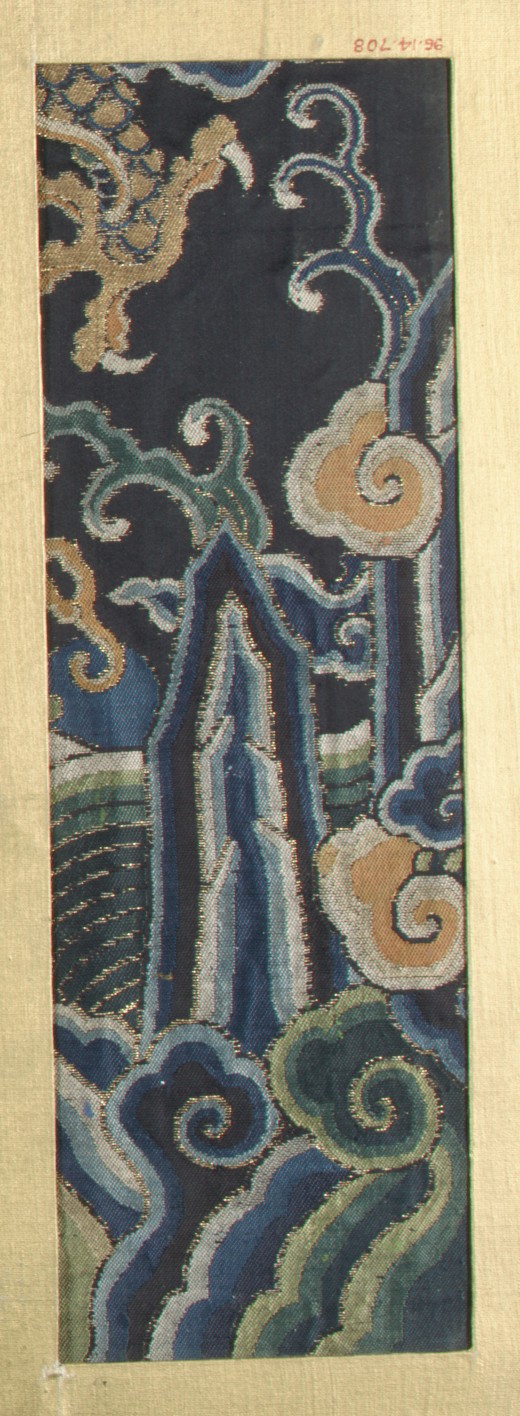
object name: piece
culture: chinese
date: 1662-1722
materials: silk